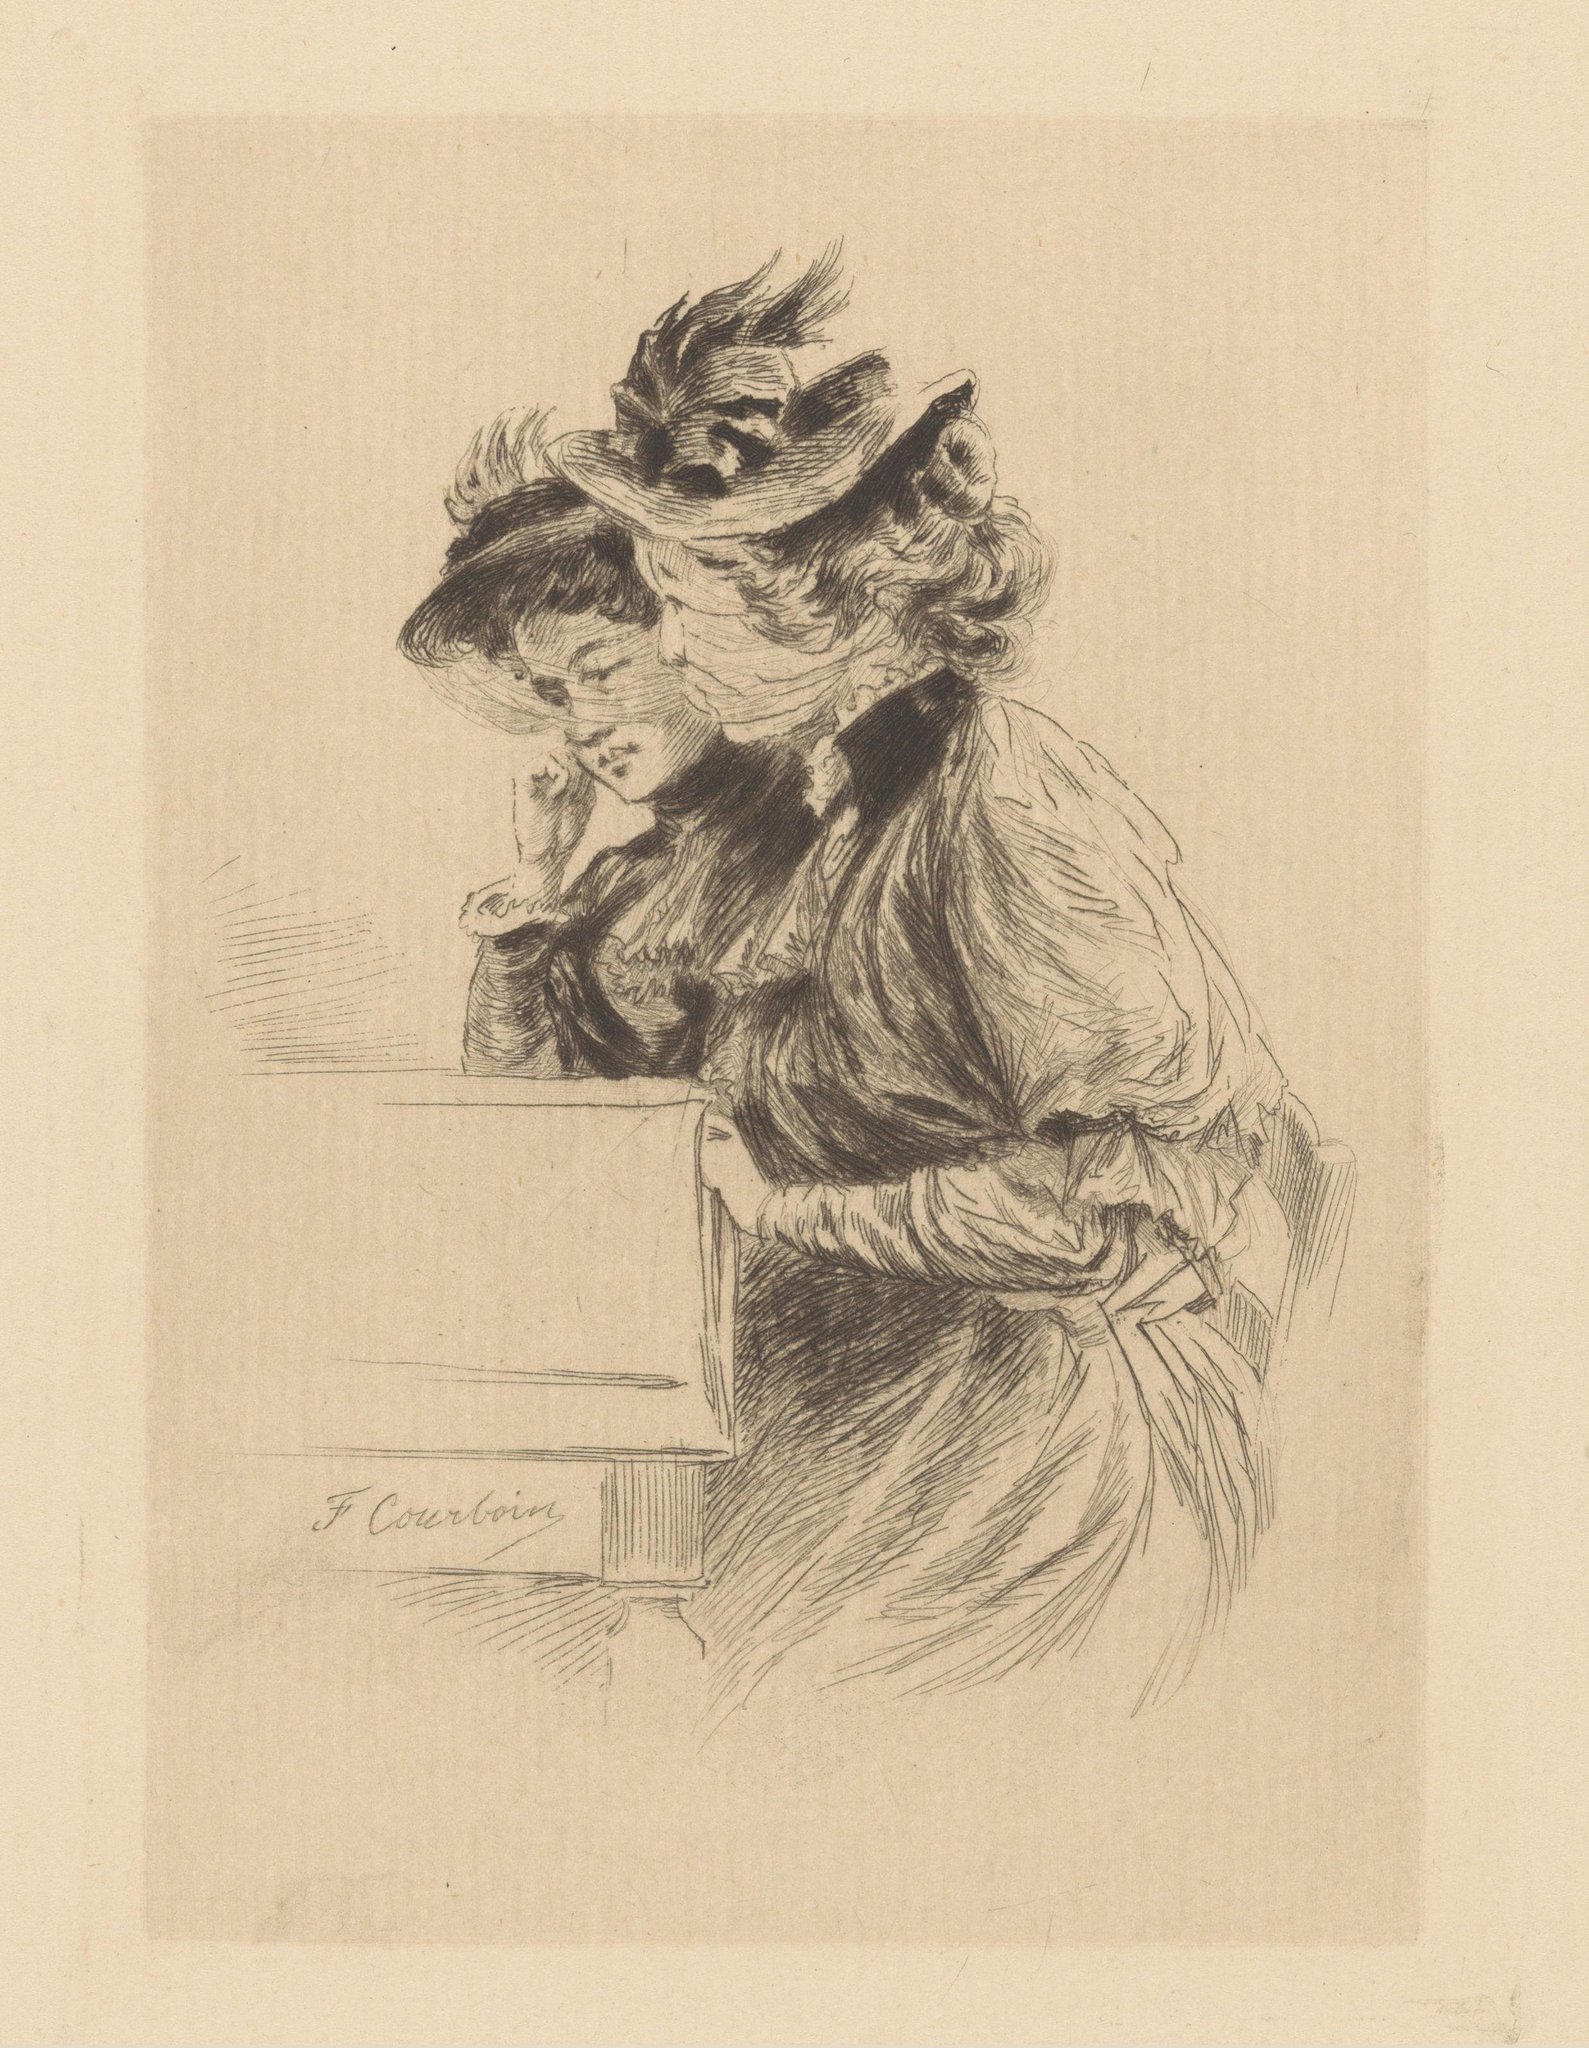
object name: print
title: Twee lezende vrouwen met hoeden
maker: françois courboin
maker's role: print maker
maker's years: 1865-1926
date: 1875-1926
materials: paper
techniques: drypoint, intaglio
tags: newspaper, news-sheet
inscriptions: collector's mark: Lugt 2228